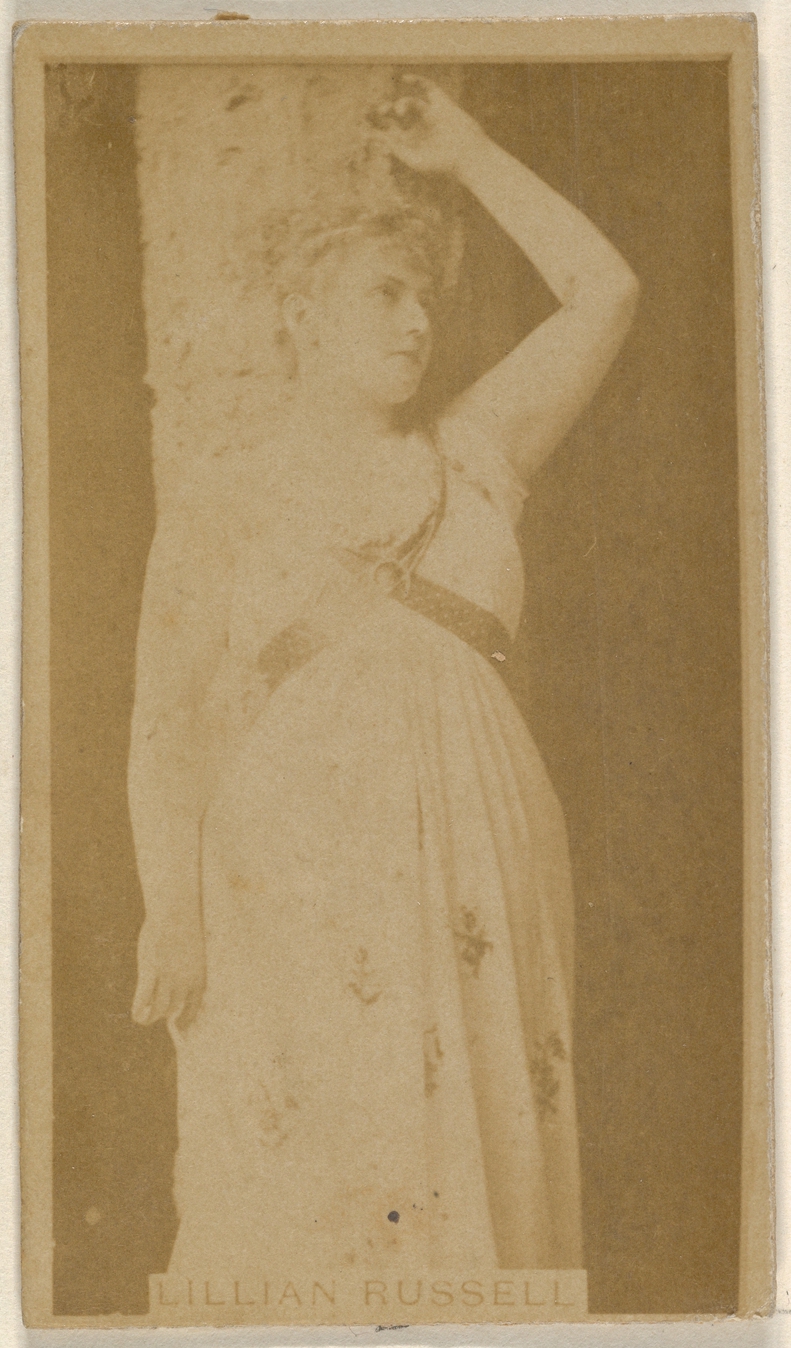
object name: photograph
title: Lillian Russell, from the Actors and Actresses series (N45, Type 8) for Virginia Brights Cigarettes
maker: allen & ginter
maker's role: publisher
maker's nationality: american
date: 1888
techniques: albumen silver print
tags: portraits,women,actresses